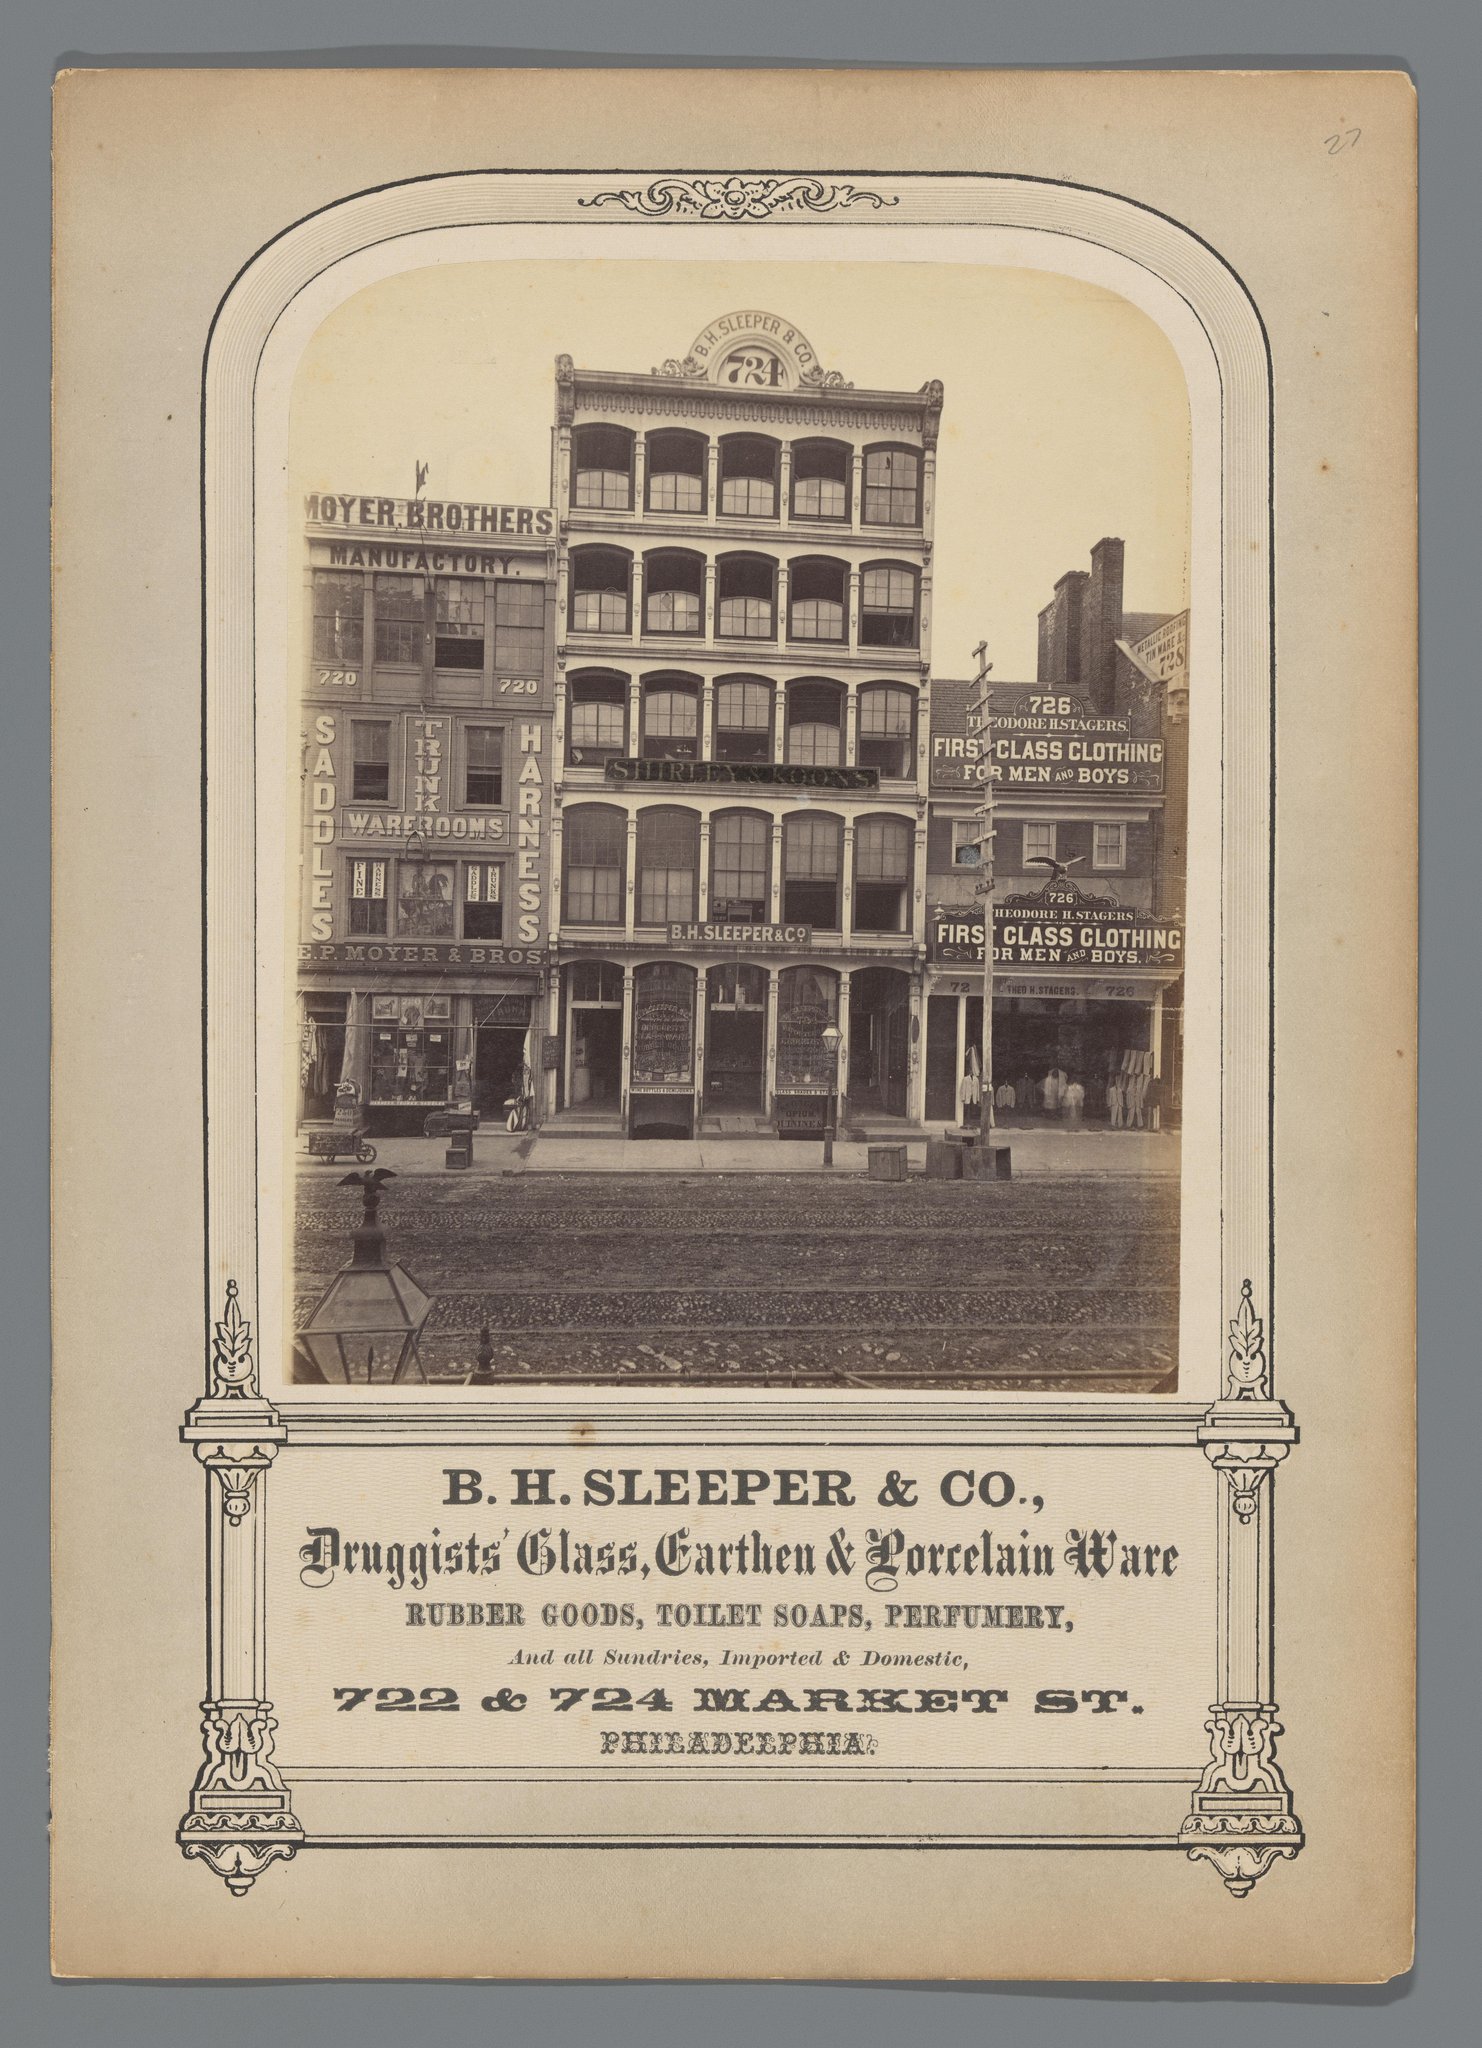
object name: photograph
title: Façade van B.H. Sleeper & Co., Druggists’ Glass, earthen & Porcelain ware, Rubber Goods, Toilet Soaps, Perfumery, …, 722 & 724 Market Street, Philadelphia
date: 1871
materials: cardboard, paper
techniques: albumen print, printed materials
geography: philadelphia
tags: philadelphia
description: Pagina uit Gallery of Arts and Manufactures of Philadelphia.